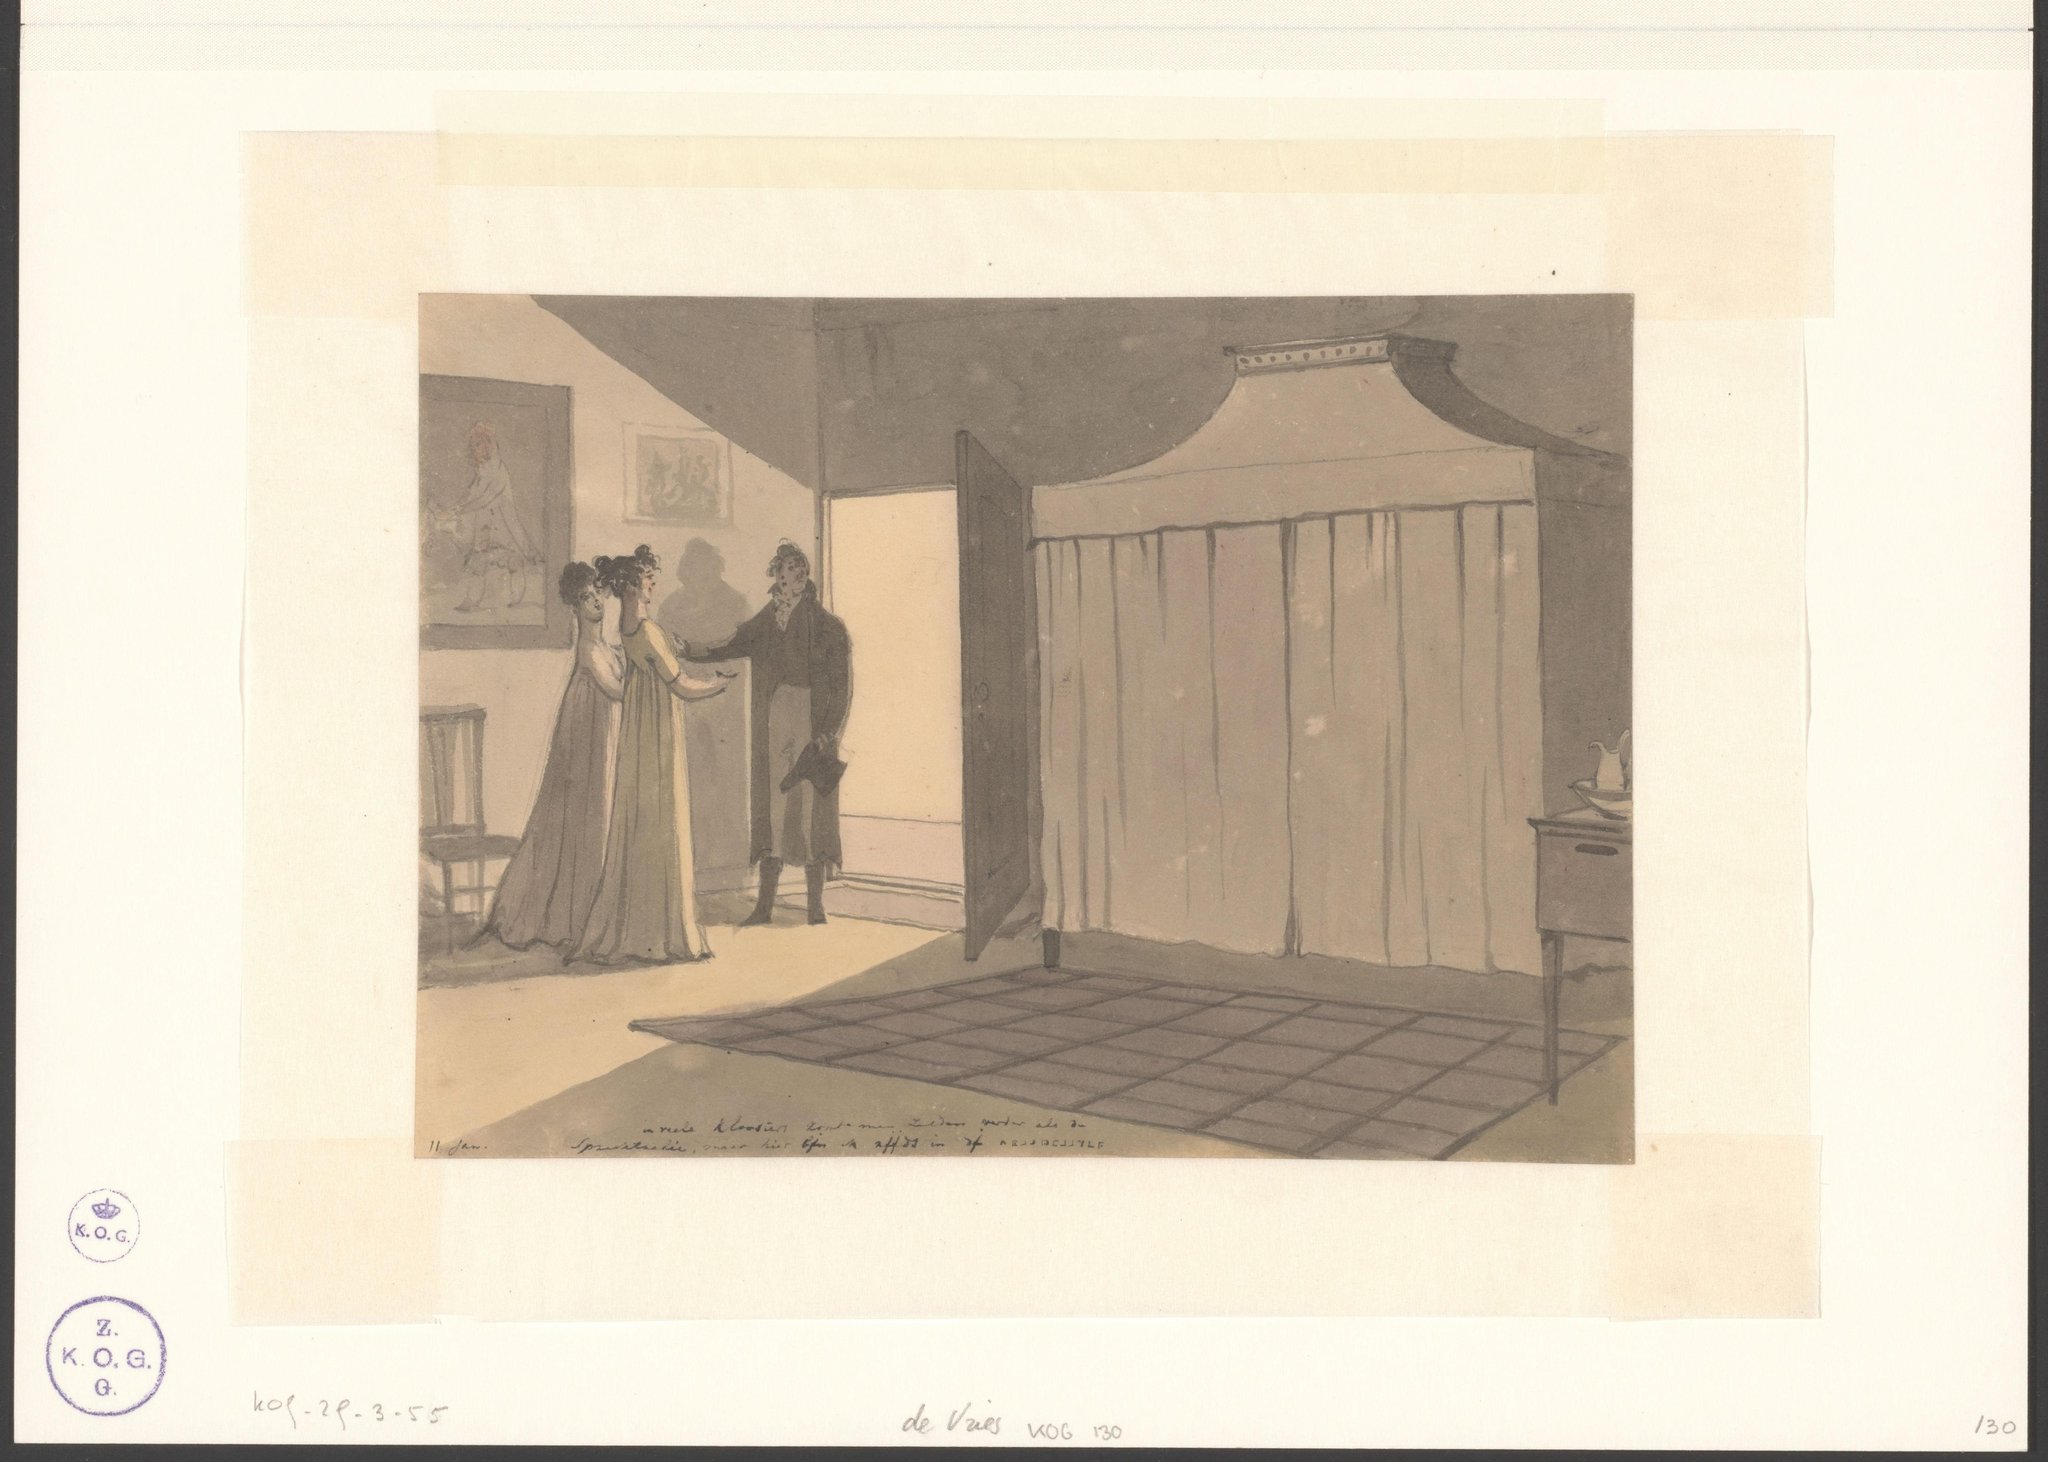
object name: drawing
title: Christiaan Andriessen staat in de deuropening van de slaapkamer van twee dames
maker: christiaan andriessen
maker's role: draughtsman, print maker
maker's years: 1775-1846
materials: ink, paper, pencil, watercolor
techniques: brush, pen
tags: amsterdam, print maker, draughtsman, christiaan andriessen, open door, bedroom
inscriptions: inscription: ‘11 jan in oude kloosters komt men niets verder dan de spreektraalie maar hier...’, collector's mark: Lugt 1641a, inscription: ‘J Andriessen’, collector's mark: Lugt 1641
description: Dagboekblad uit het getekende dagboek dat Christiaan Andriessen bijhield van 1805 tot en met 1808.